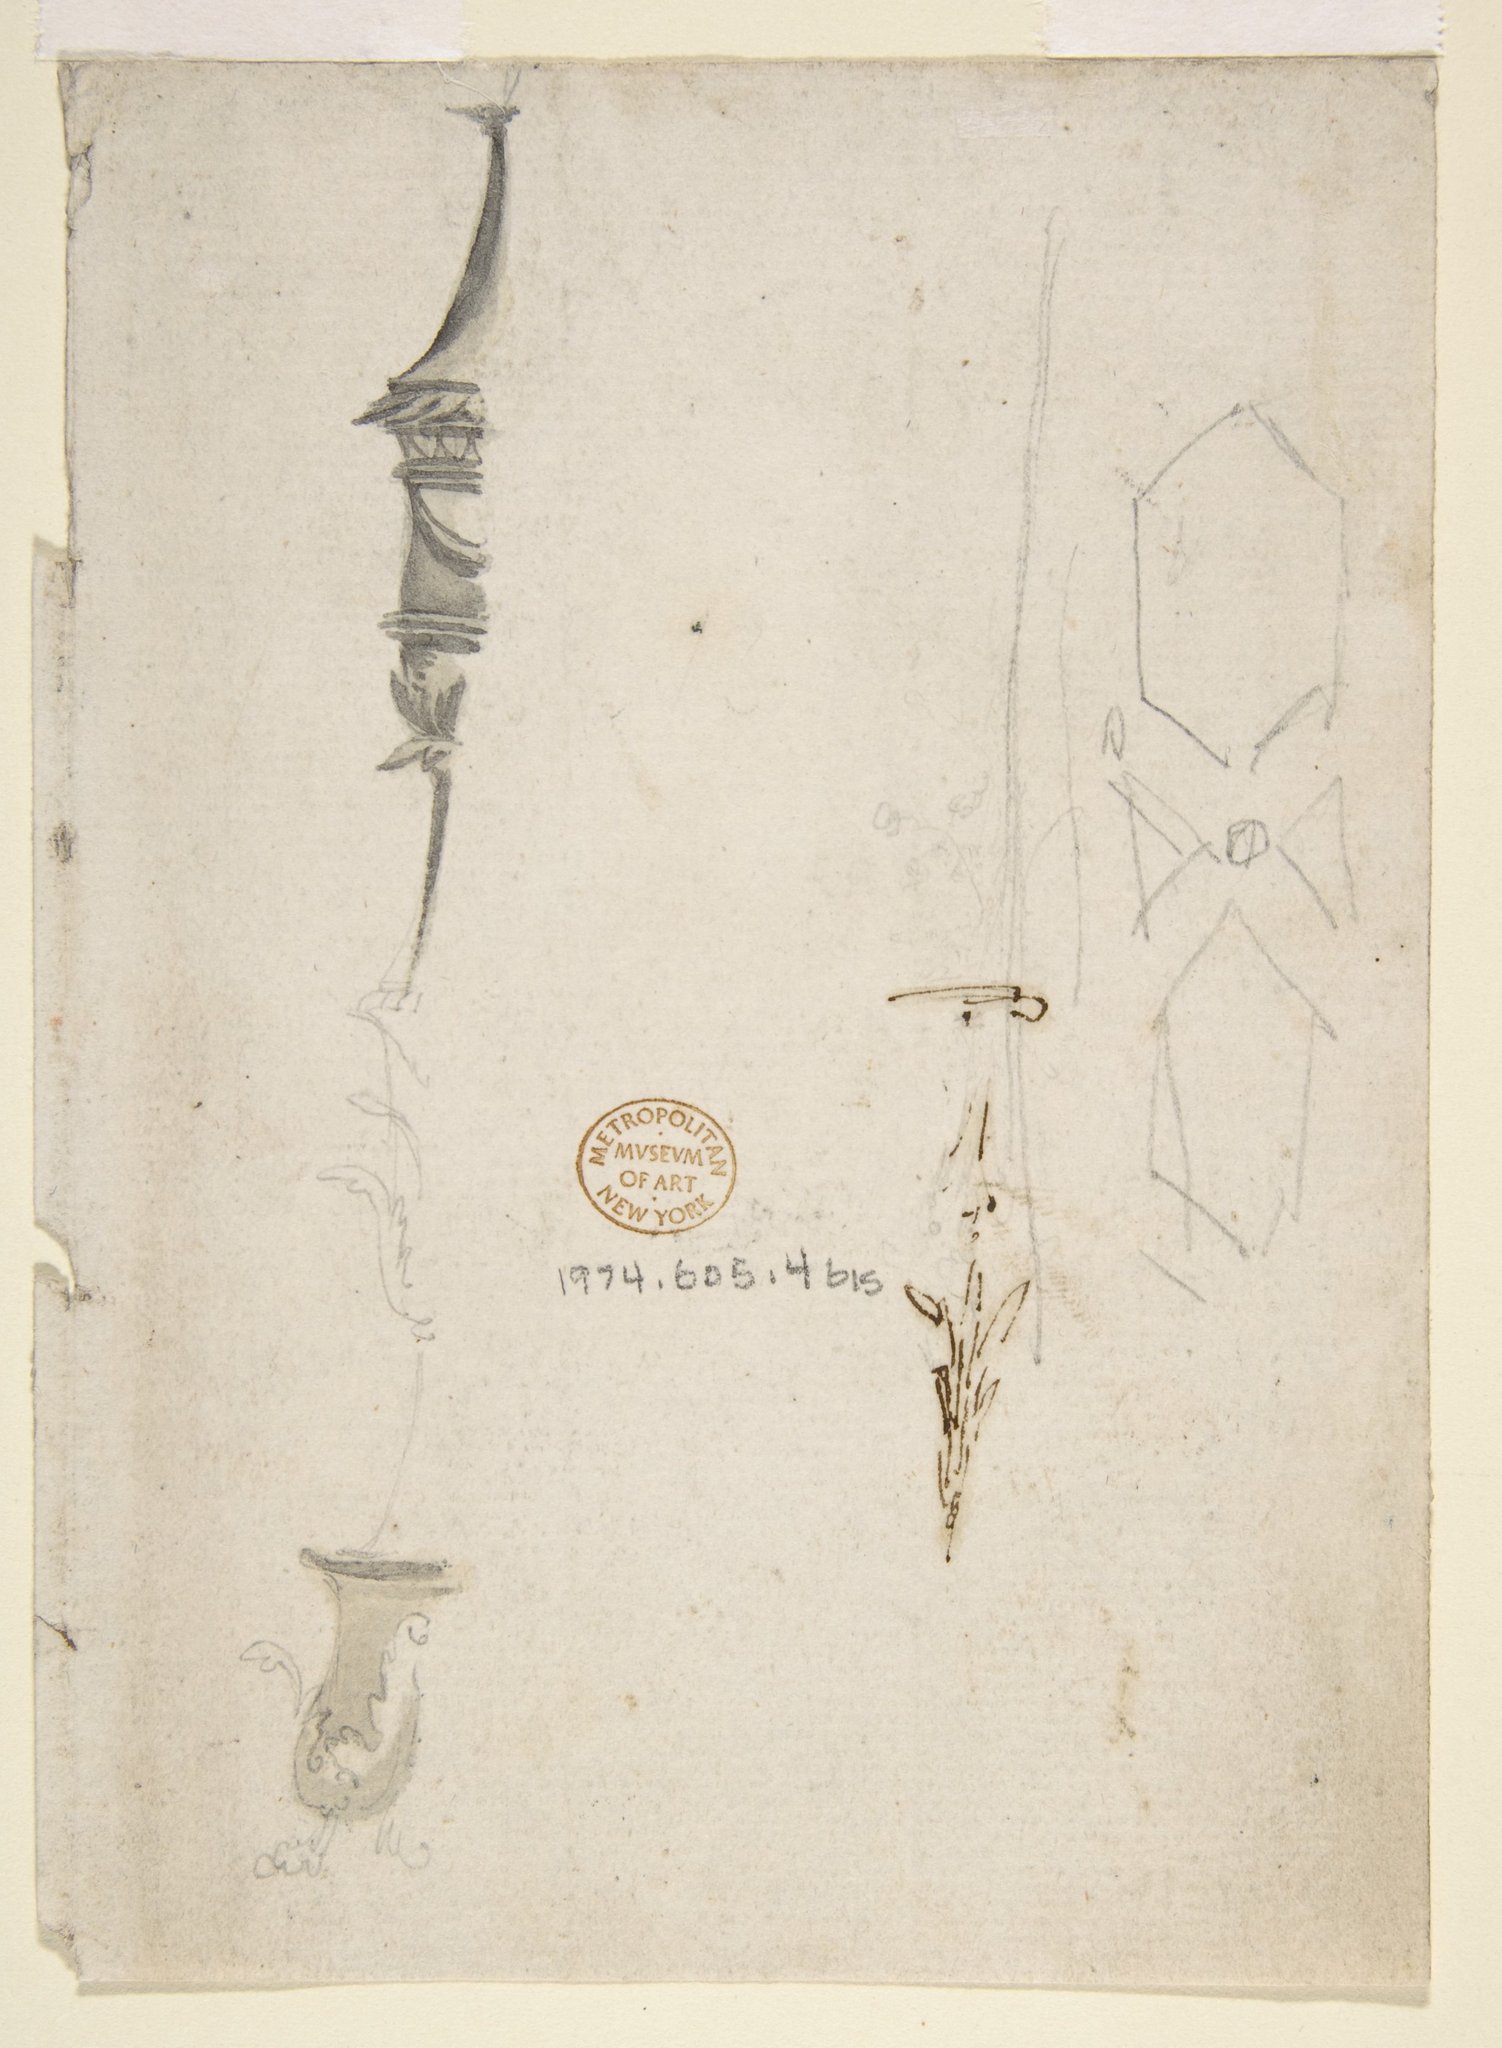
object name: drawing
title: Fragmentary Sketches of Various Ornament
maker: giovanni battista natali iii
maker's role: artist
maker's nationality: italian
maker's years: 1698-1765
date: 1698-1765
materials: graphite, ink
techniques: brush, pen, wash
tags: ornament